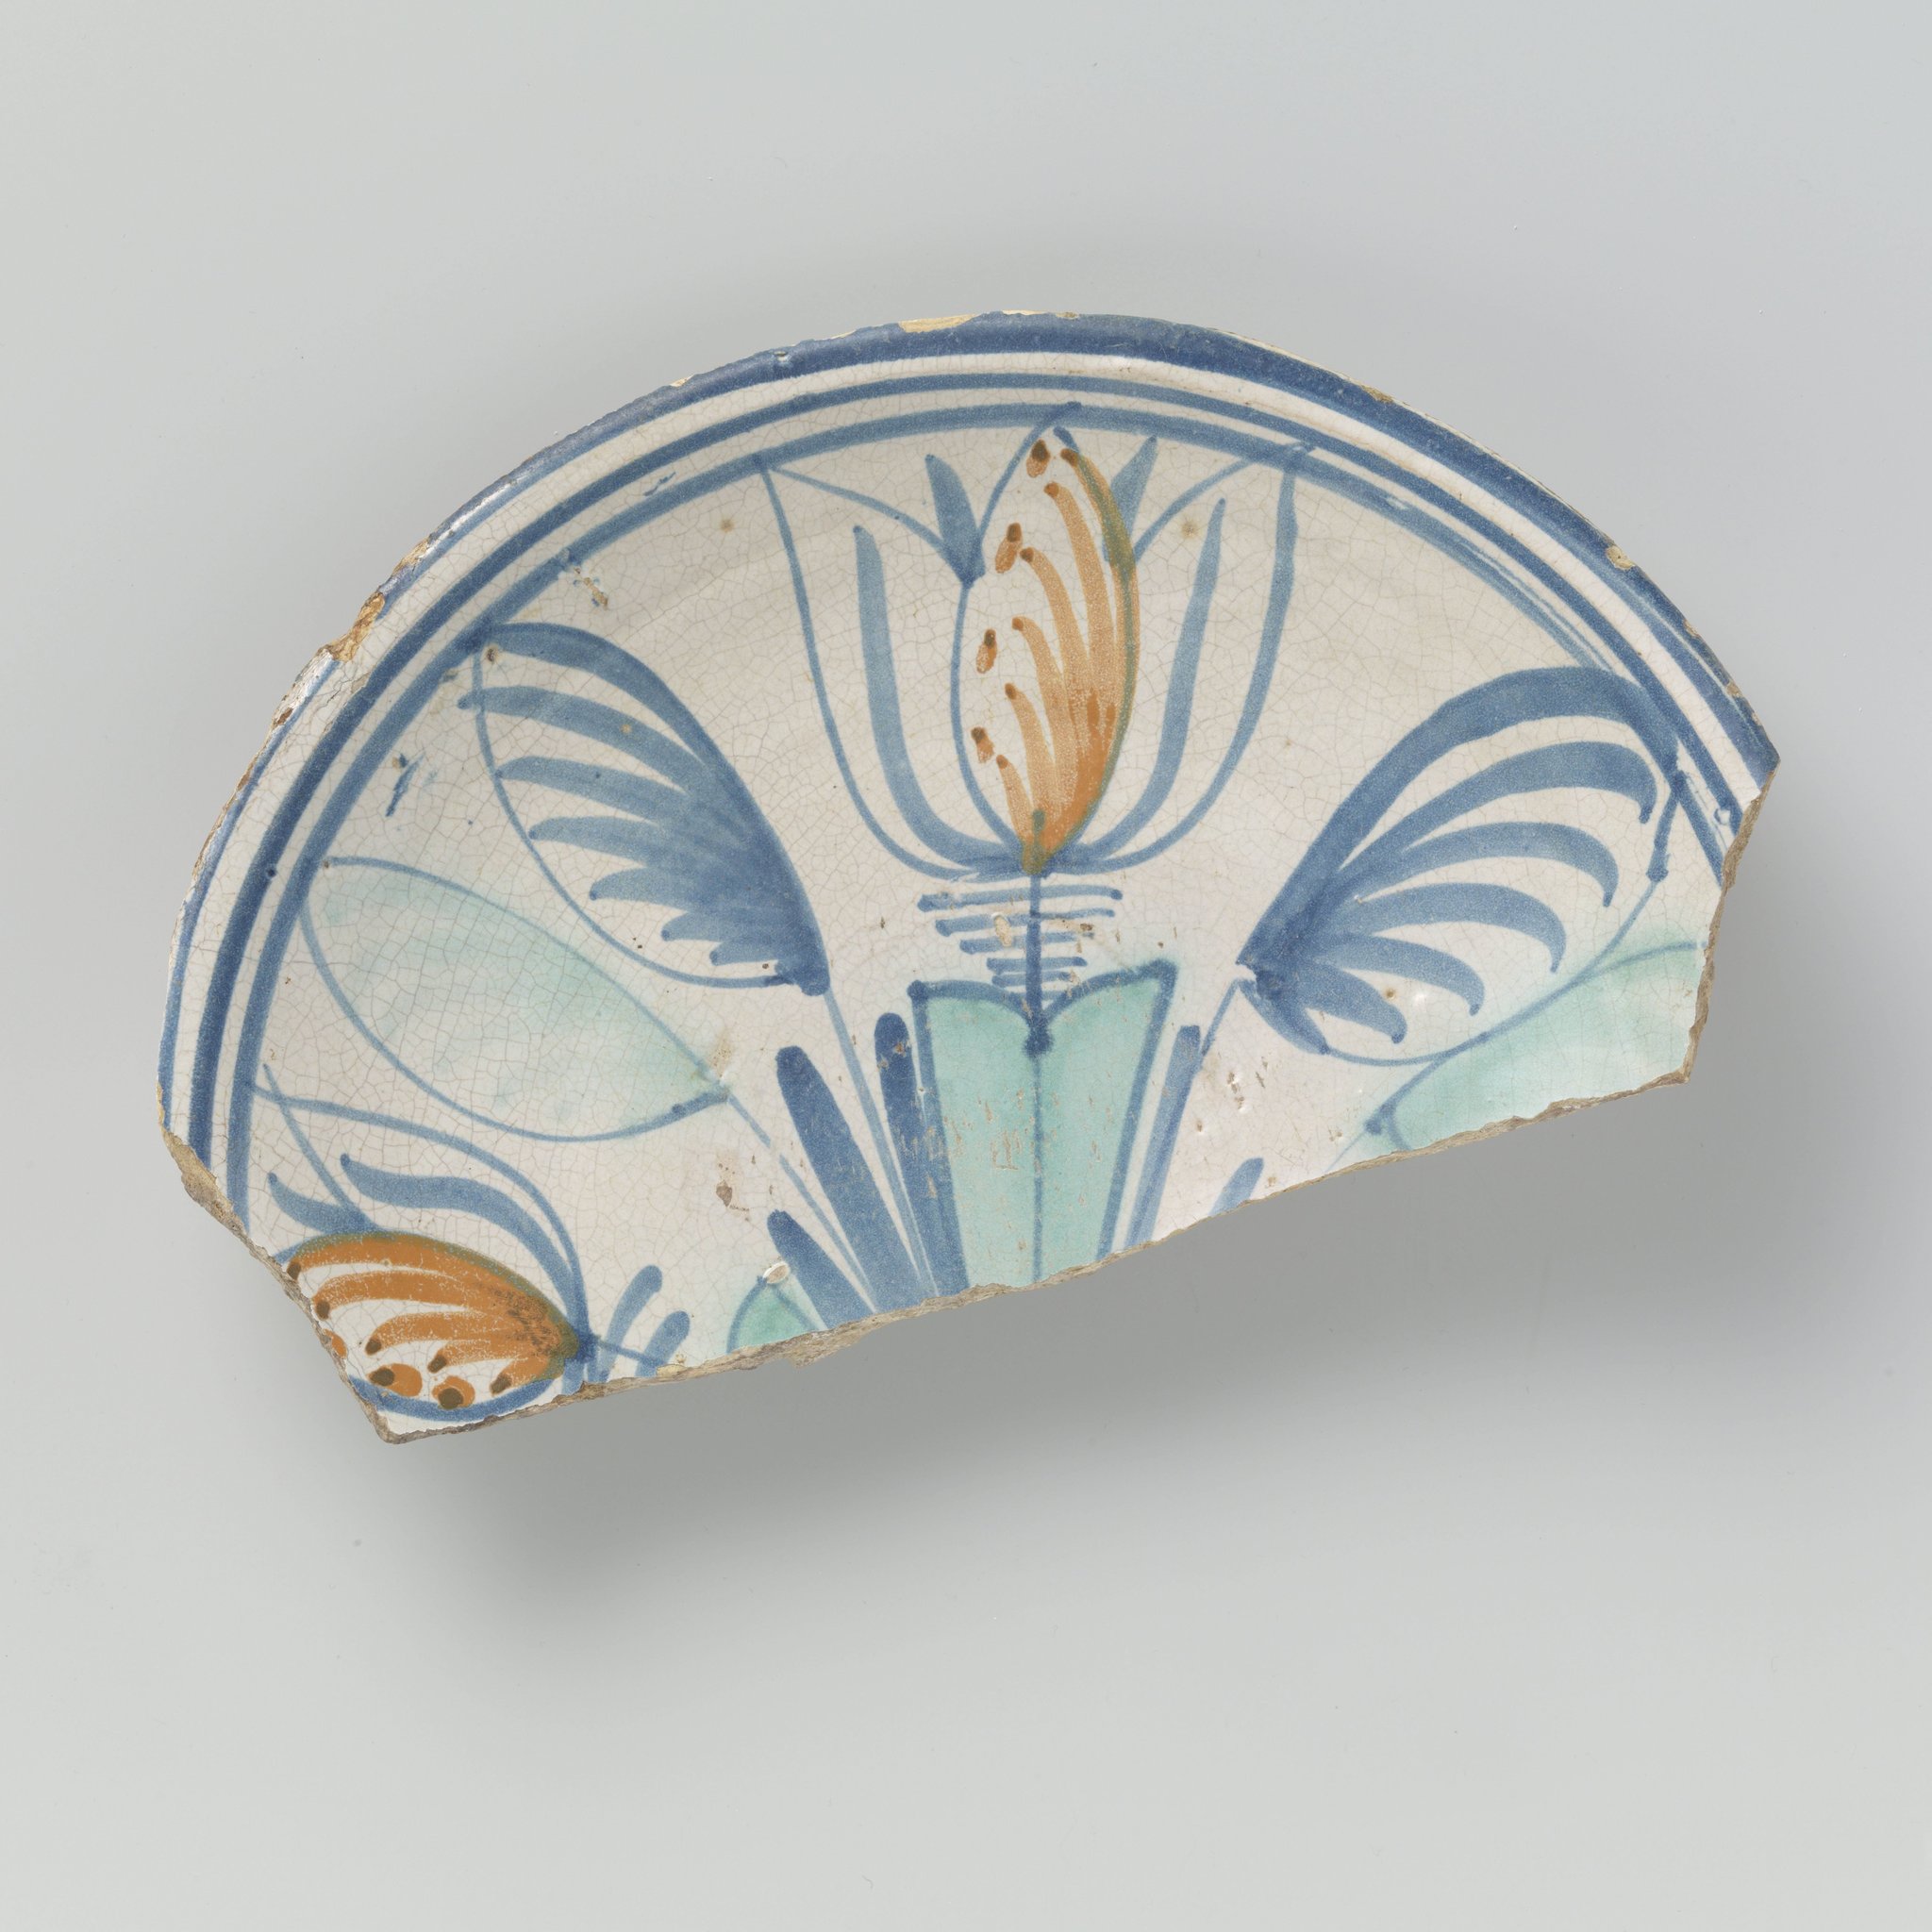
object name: platter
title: Fragment van een schotel, beschilderd met tulpen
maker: Anonymous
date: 1675-1725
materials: earthenware, glaze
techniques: maiolica, painted, polychromy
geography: england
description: Fragment van een schotel van veelkleurig beschilderde majolica. Het fragment is beschilderd met tulpen in de kleuren blauw, oranje en groen. Het fragment is opgegraven in Londen (Middlesex street).